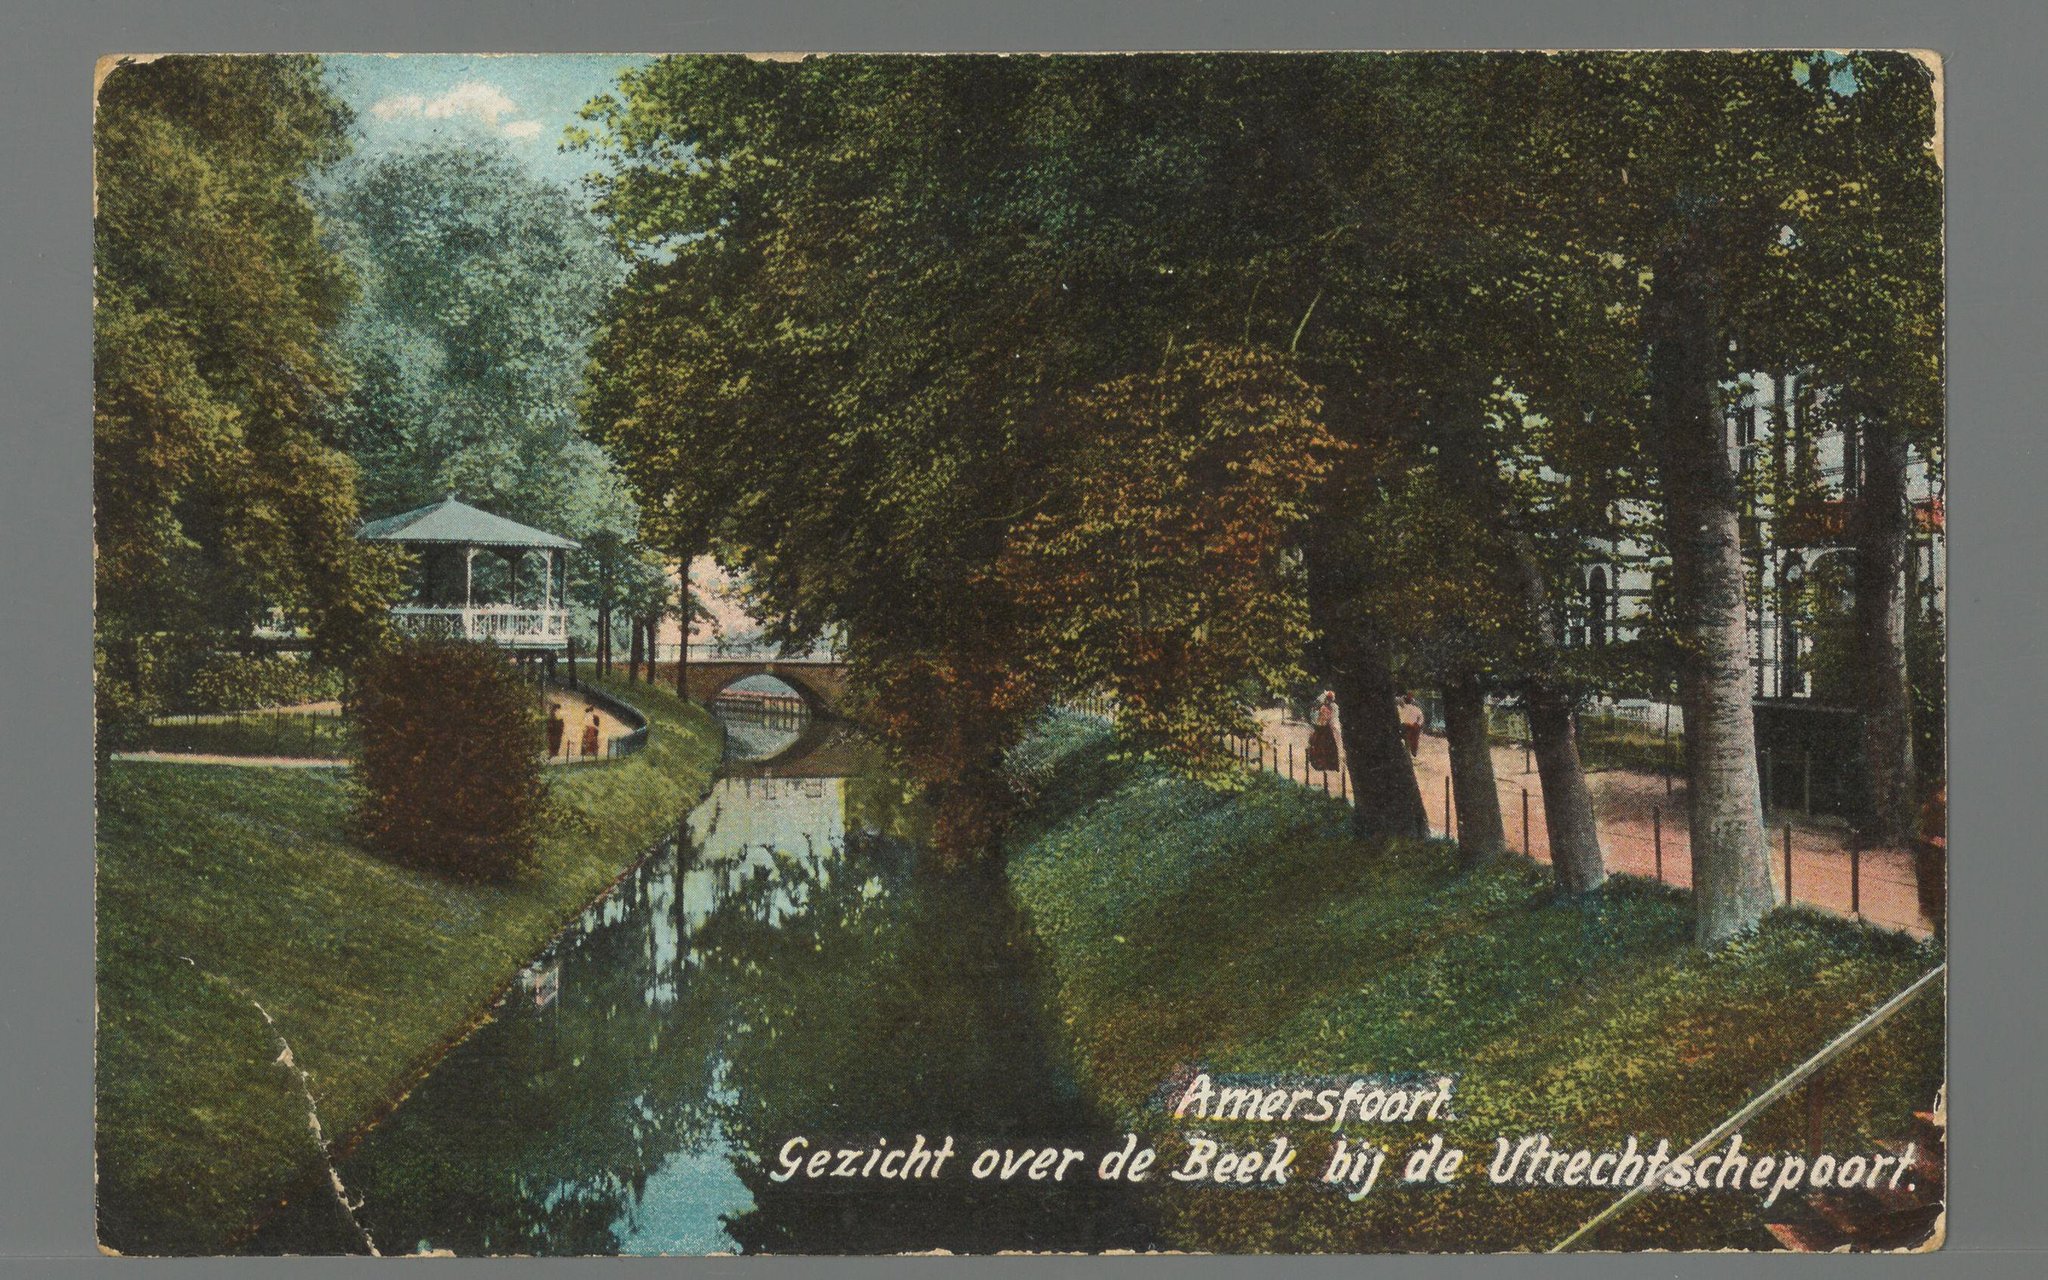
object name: ansichtkaart, prentbriefkaart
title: Amersfoort. Gezicht over de Beek bij de Utrechtschepoort.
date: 1905-1918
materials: cardboard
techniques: lithograph, writing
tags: bridge in village across river, canal, etc.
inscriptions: postage stamp